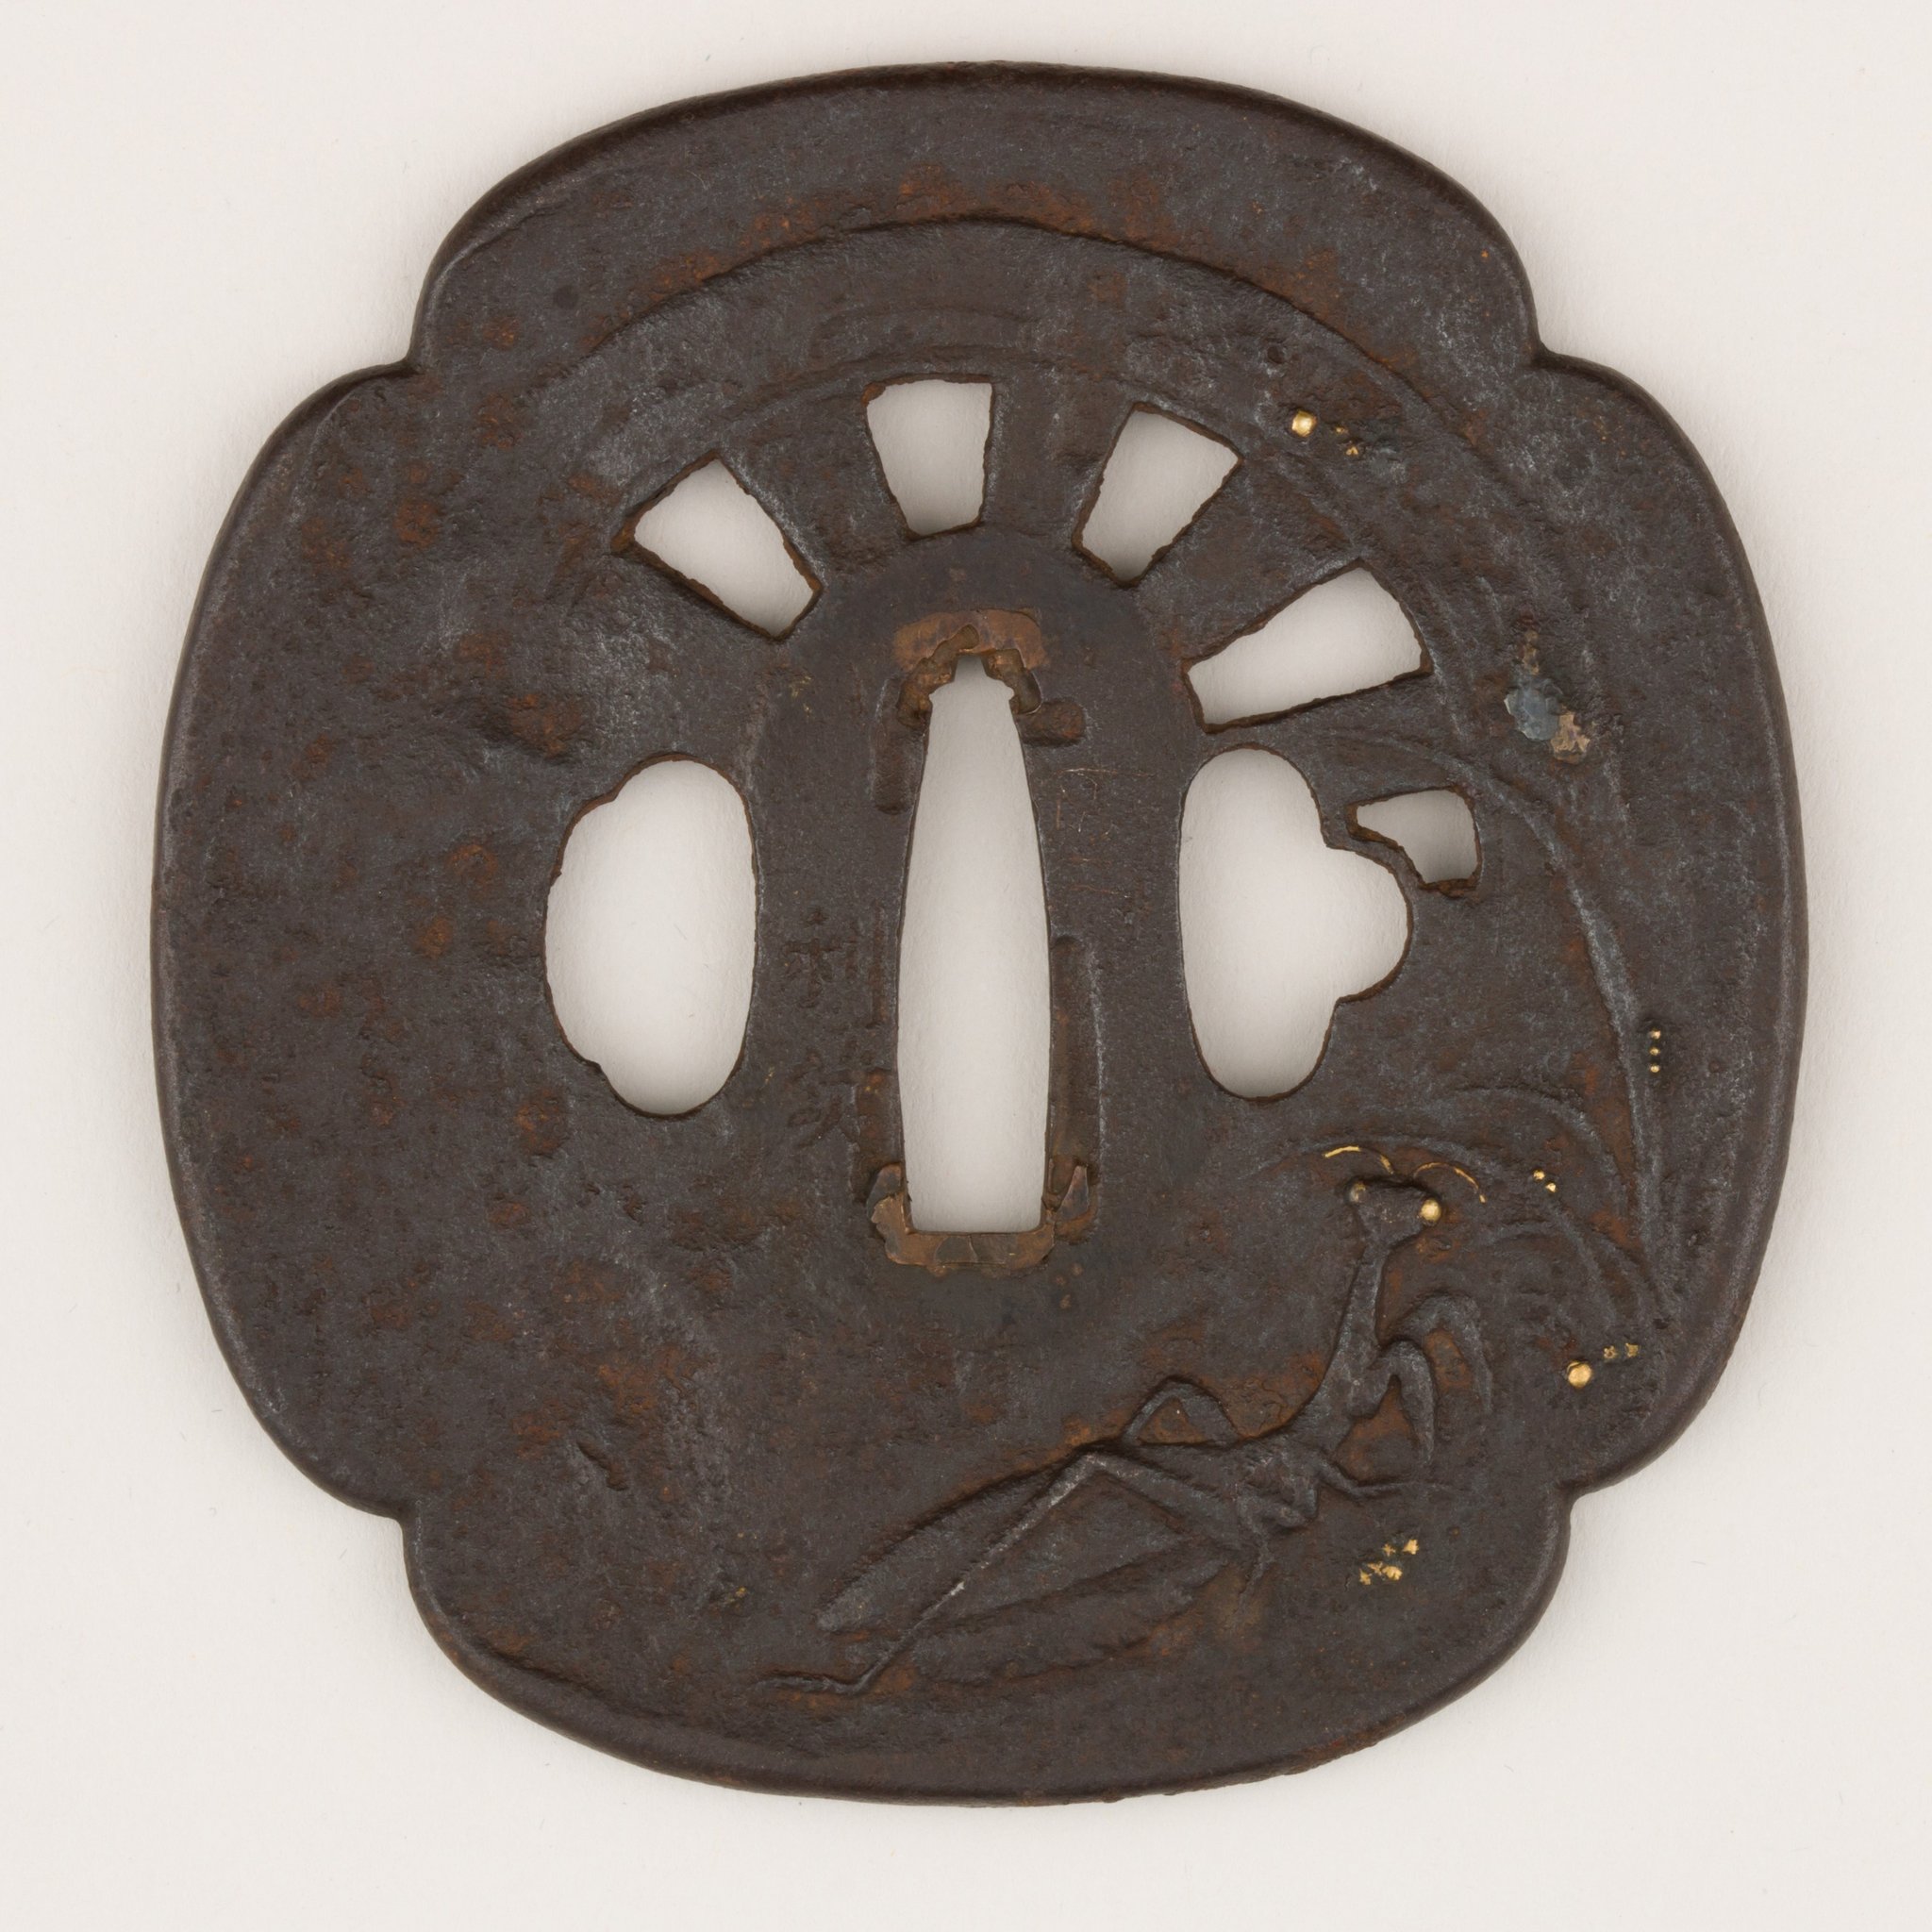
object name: sword guard tsuba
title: Sword Guard (Tsuba)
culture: japanese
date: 1615-1868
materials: copper, gold, iron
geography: japan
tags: insects